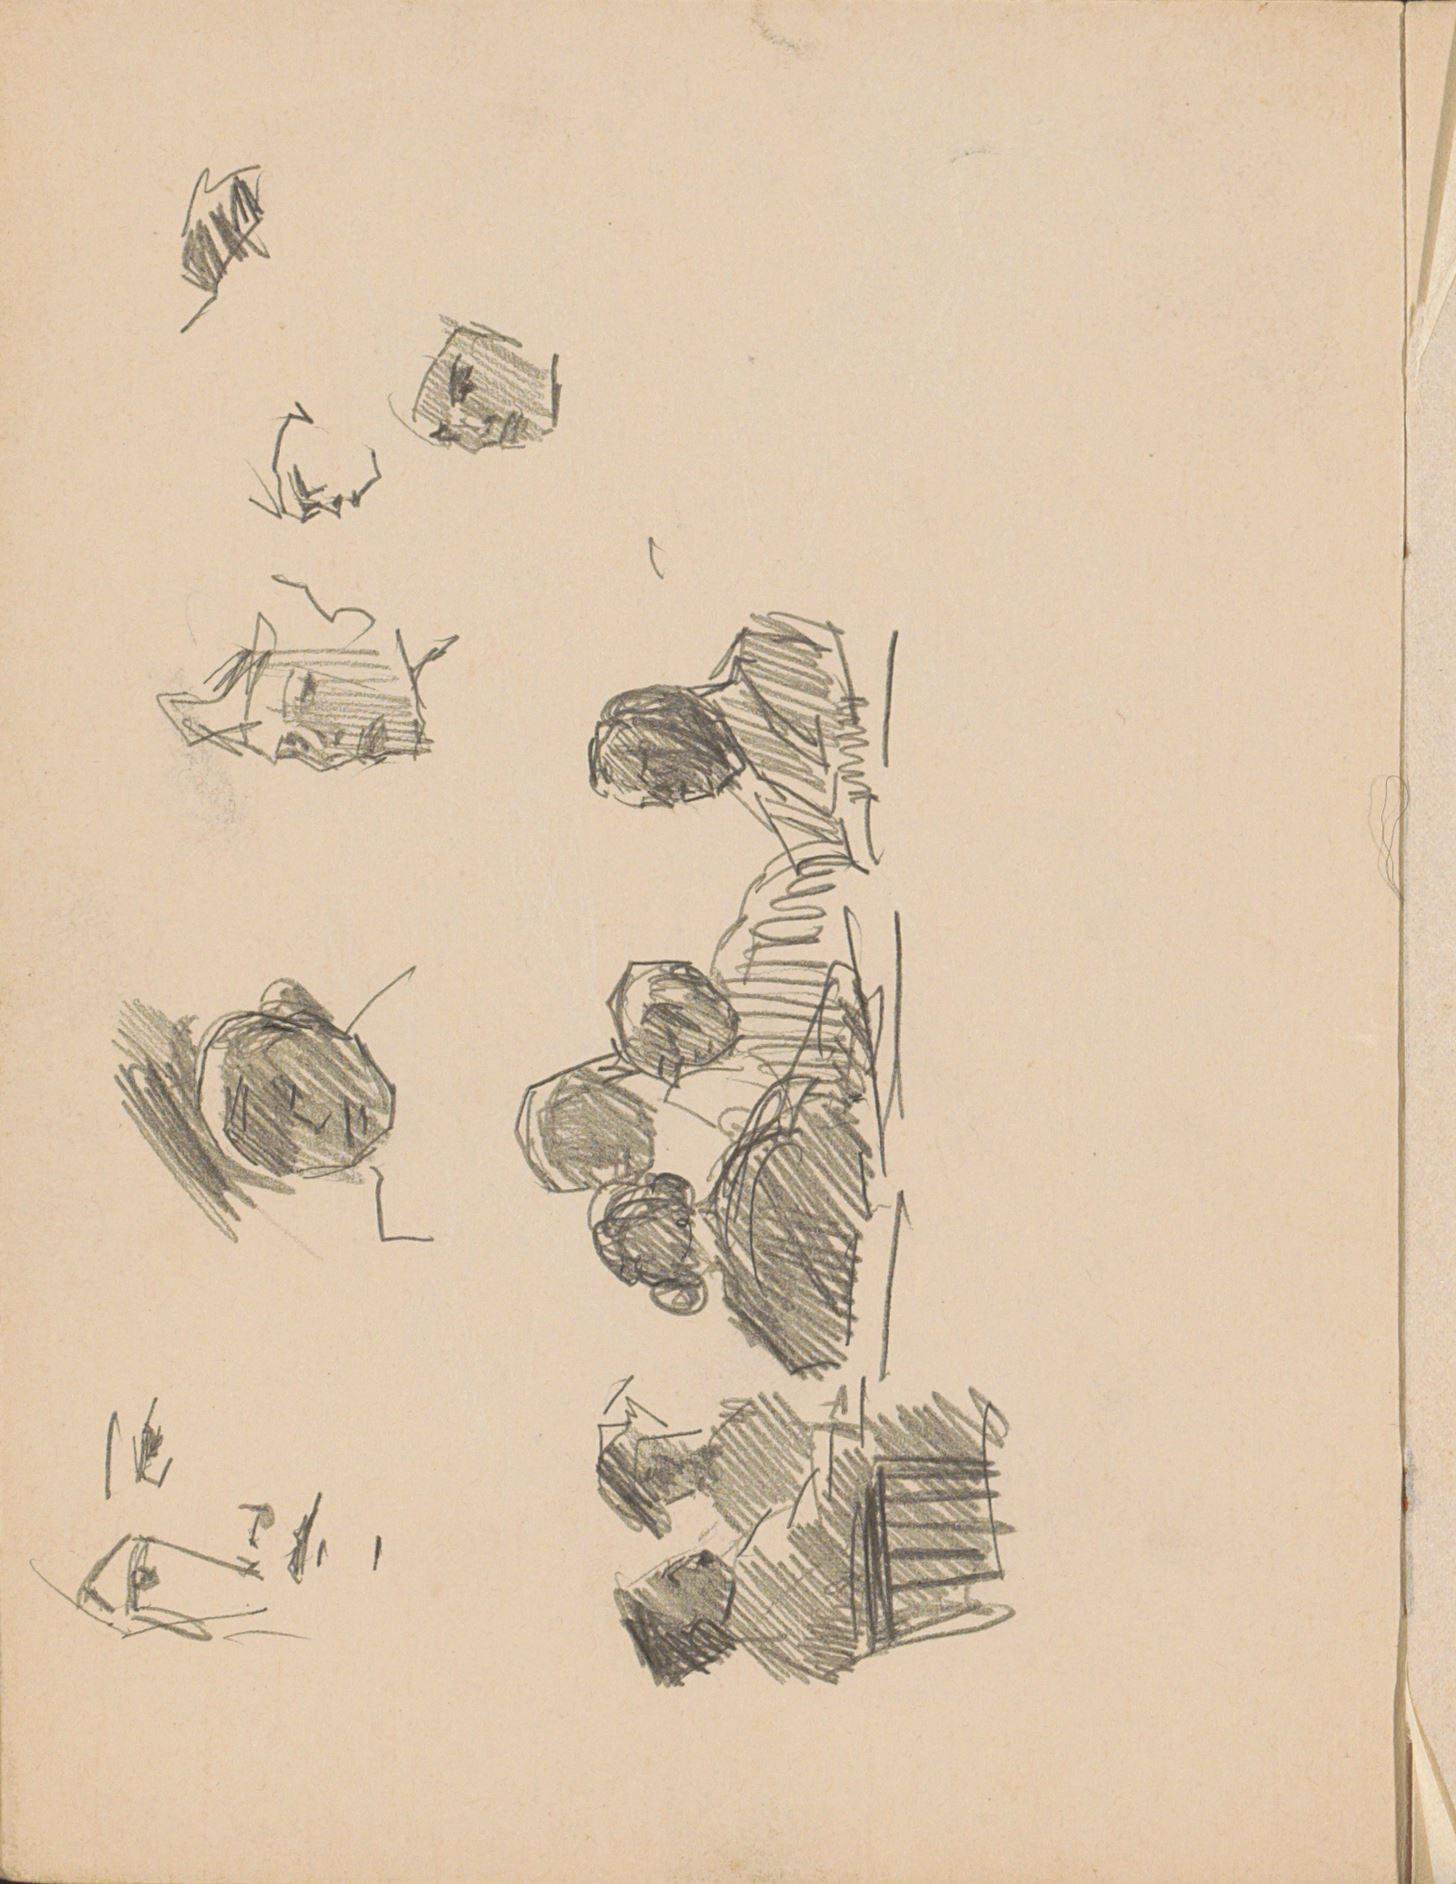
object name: sketchbook leaf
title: Studieblad met gezichten en zittende figuren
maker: isaac israels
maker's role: draughtsman, painter, print maker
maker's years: 1865-1934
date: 1921-1922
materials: paper, pencil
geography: dutch east indies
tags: asiatic races and peoples, adult man (+ sitting), face, dutch east indies, the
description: Indische figuurstudies. Pagina 10 uit schetsboek XXXIV met 24 pagina's.